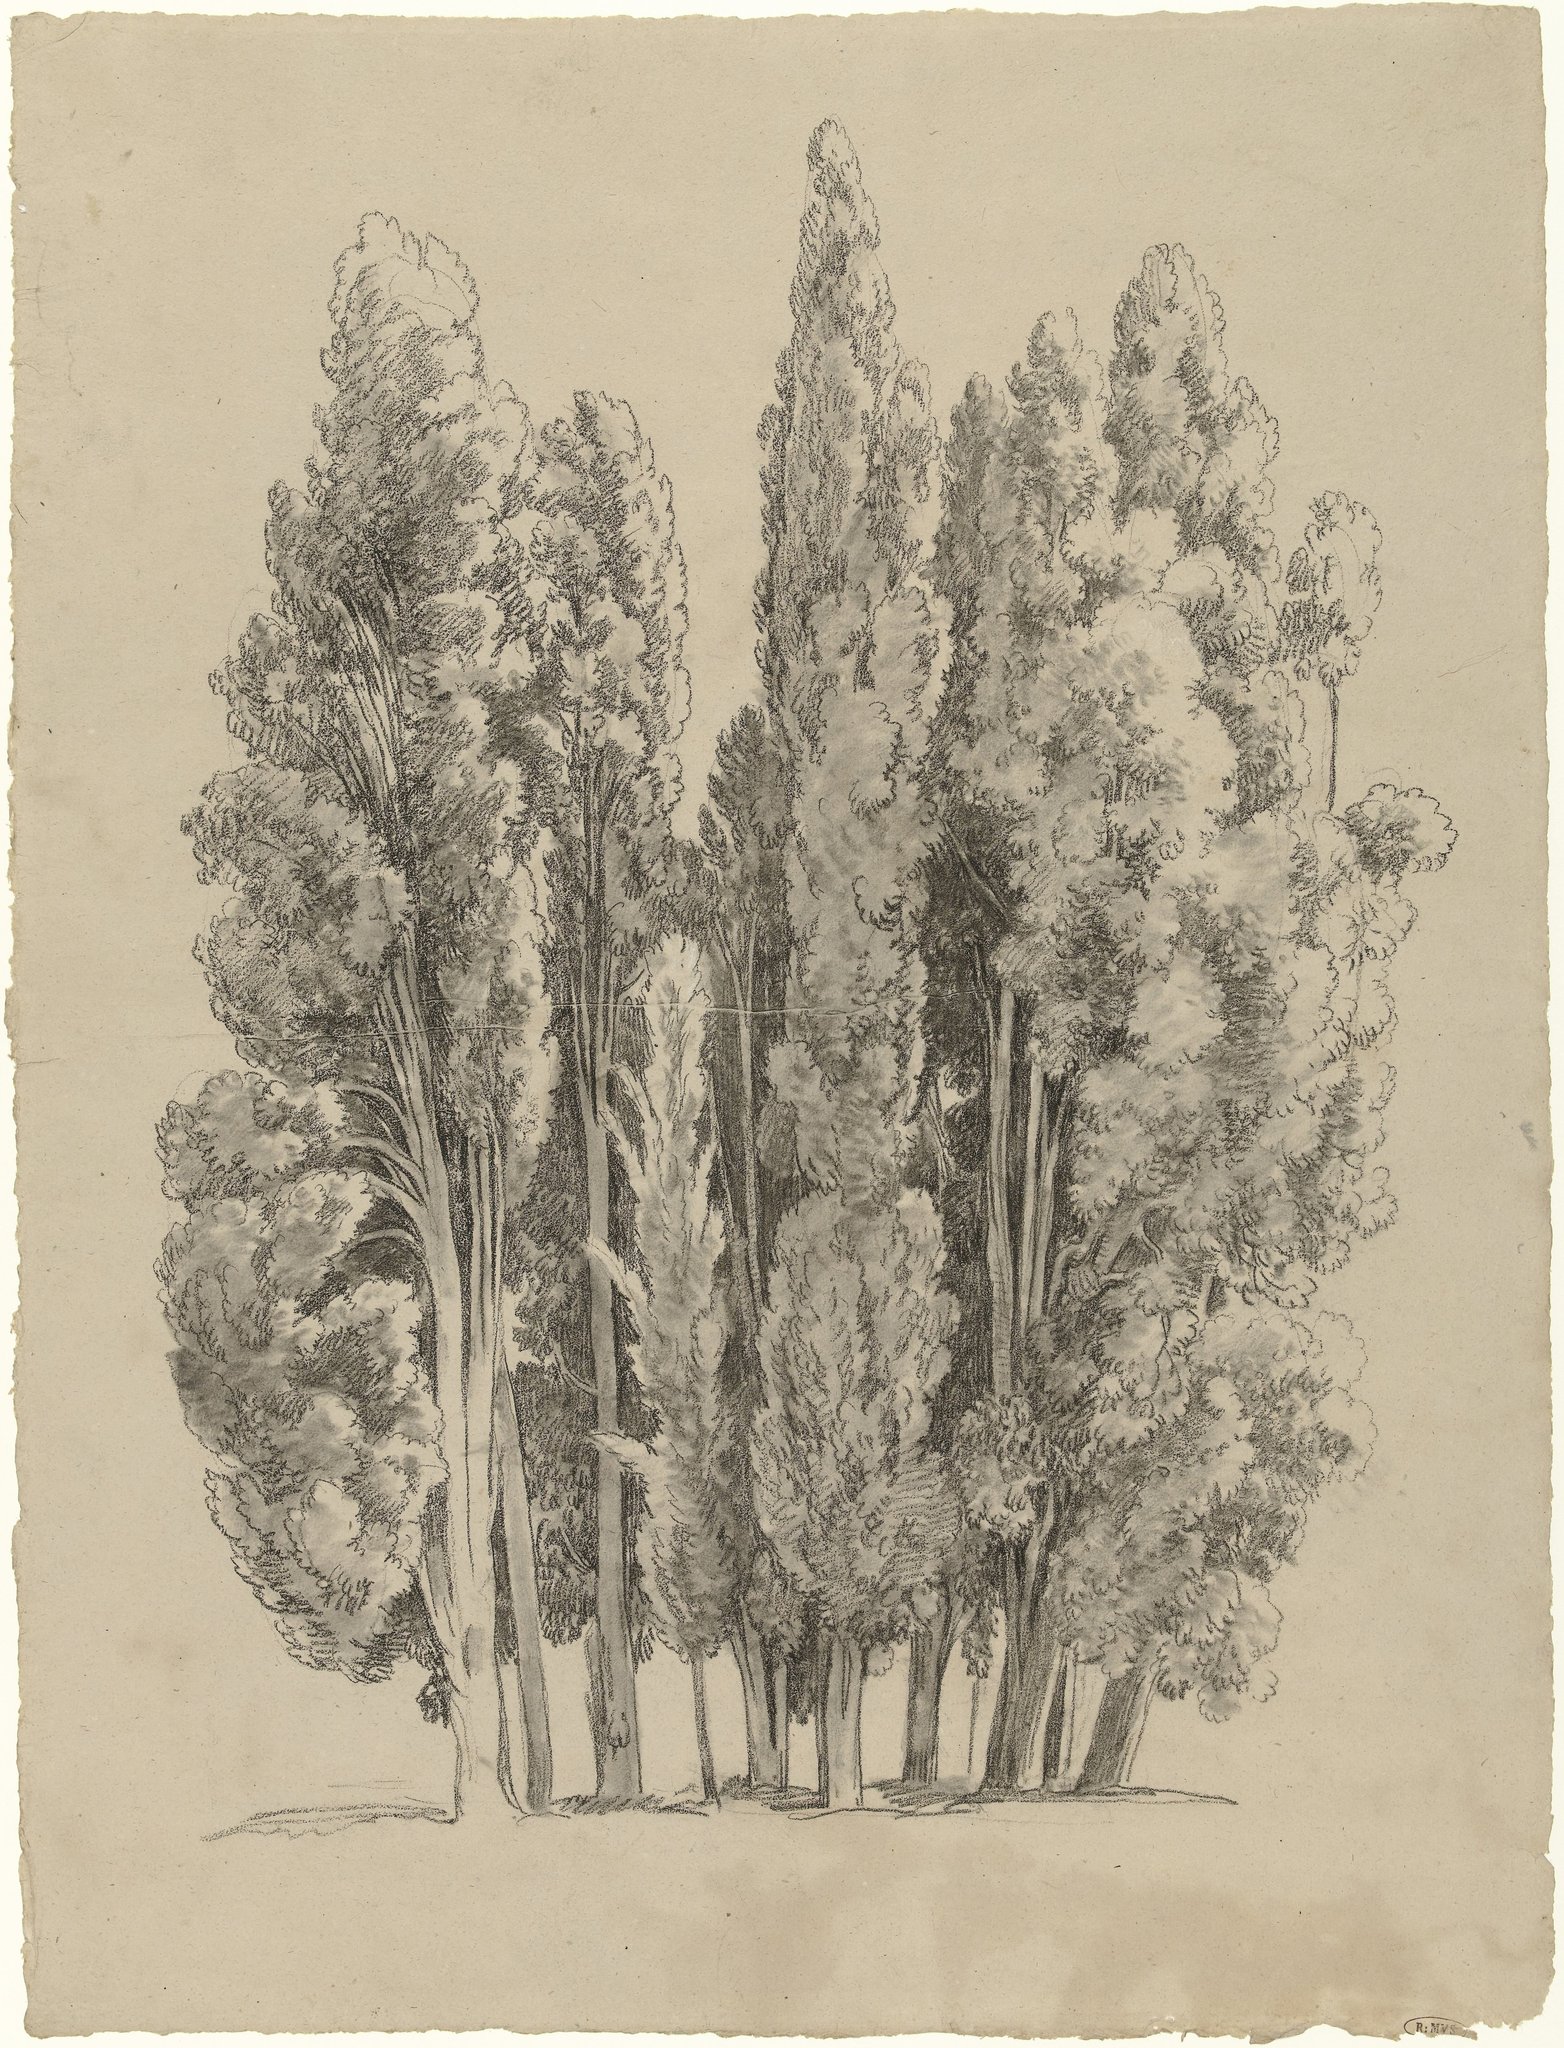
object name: drawing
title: Groep cipressen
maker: hendrik voogd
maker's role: draughtsman, painter, print maker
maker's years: 1768-1839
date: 1788-1839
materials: charcoal, paper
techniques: stumping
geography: rome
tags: trees: cypress